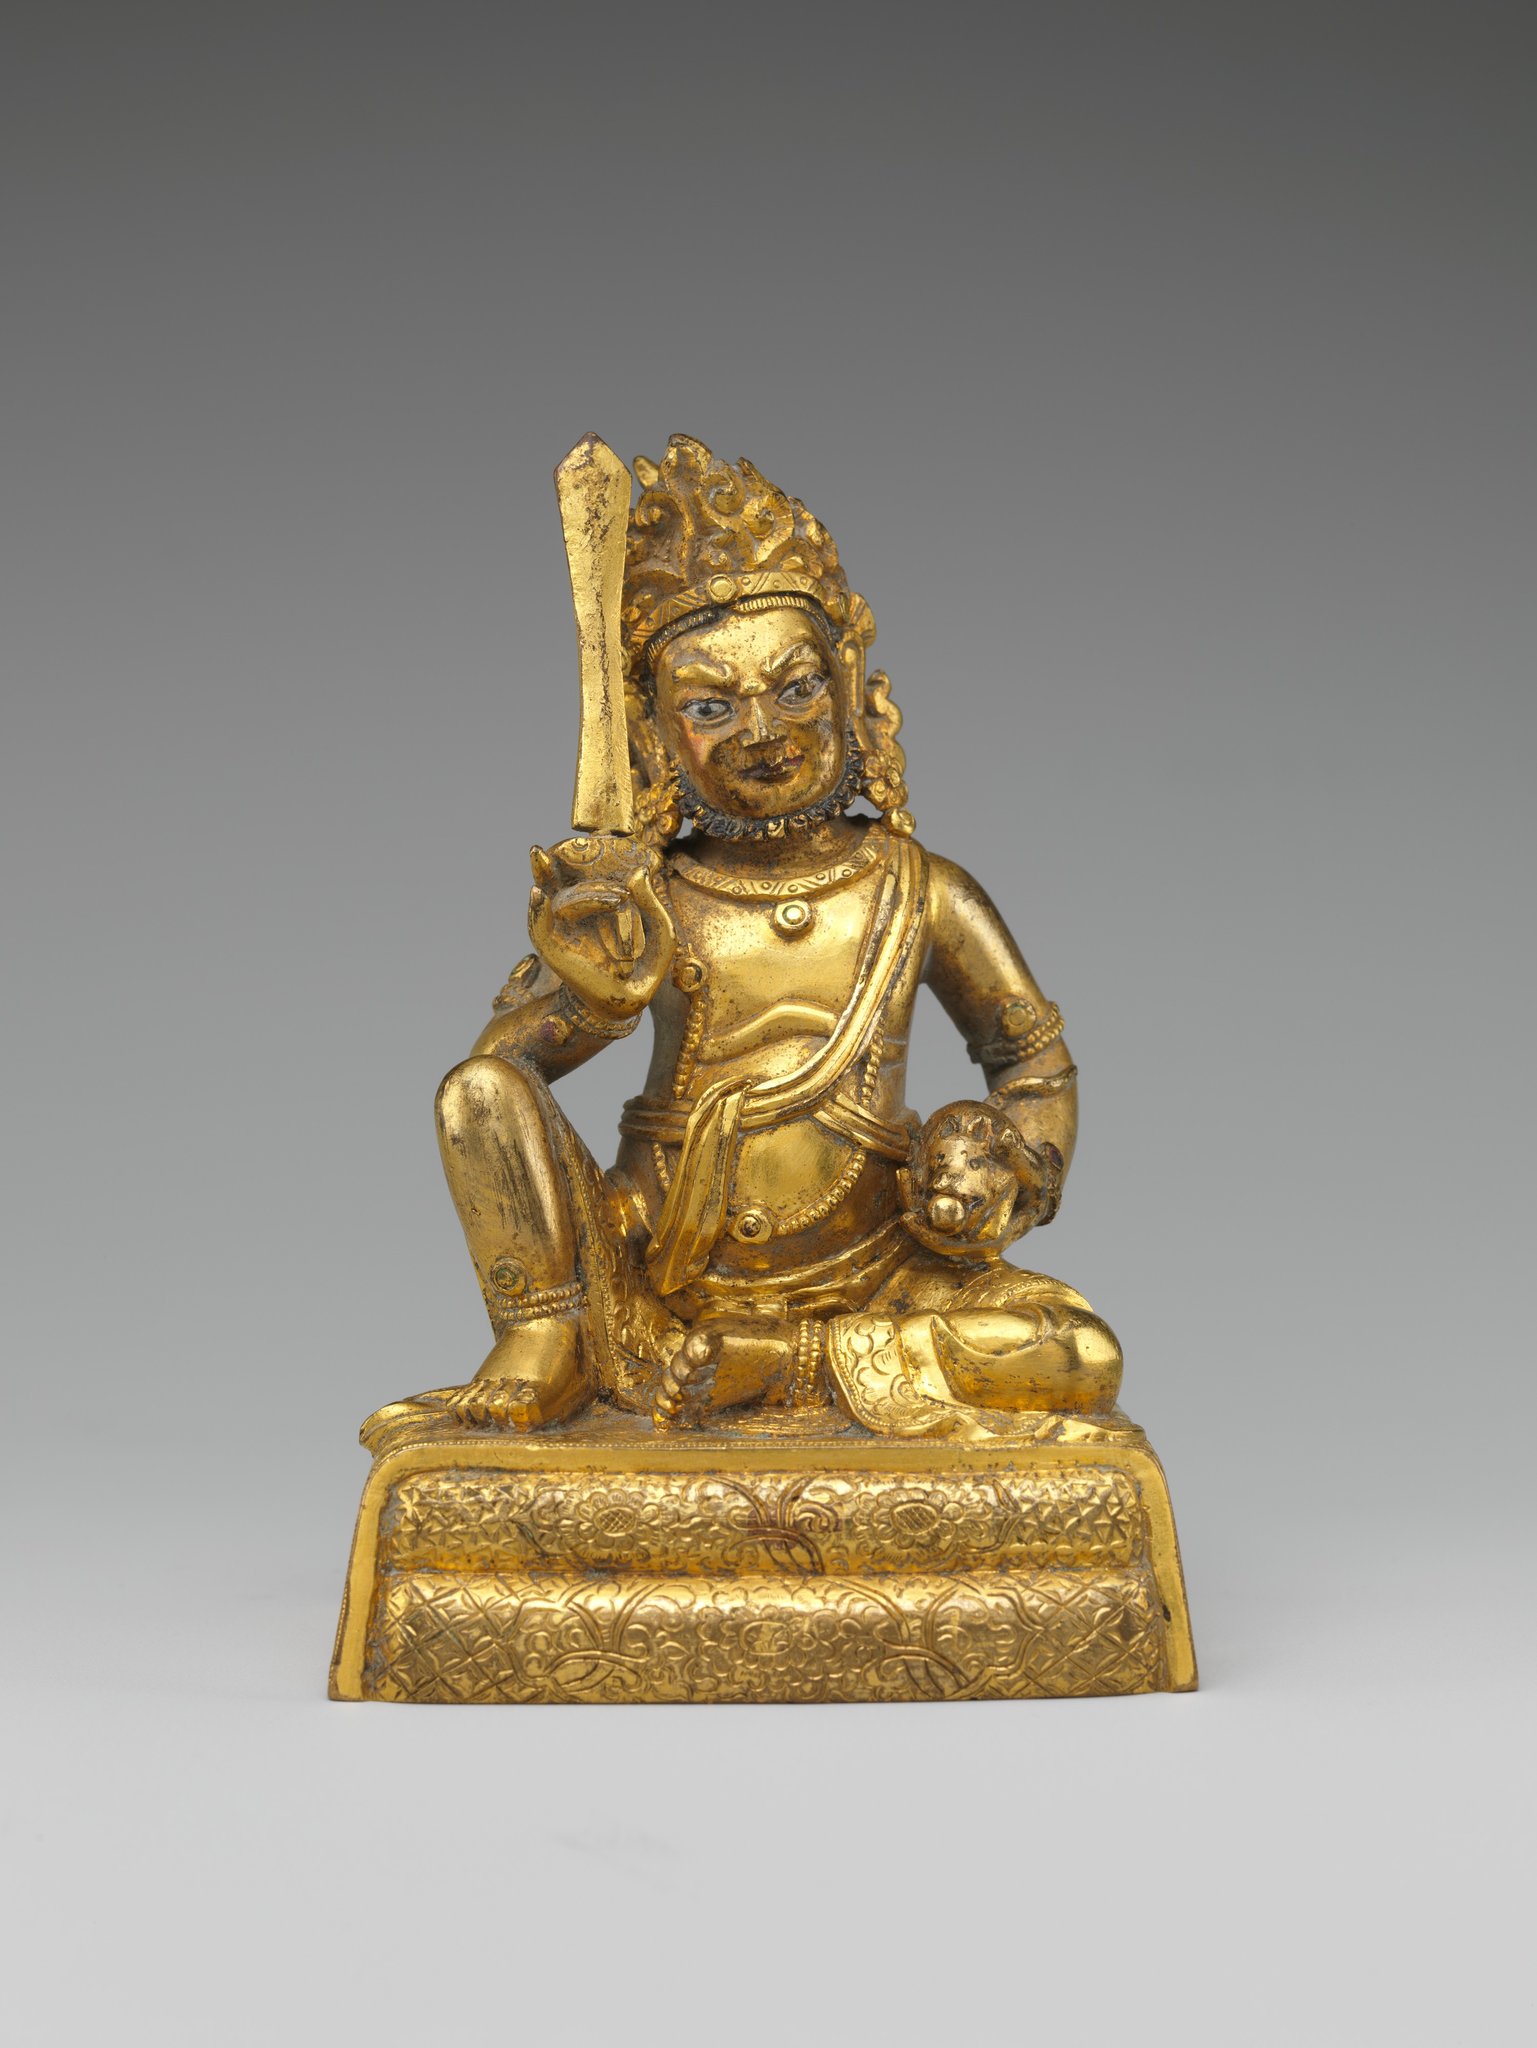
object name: figurine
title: Vaishravana as Kubera (Dou Wen Tian)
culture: china or mongolia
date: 1801-1900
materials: brass, pigment, wax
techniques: casting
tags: hinduism